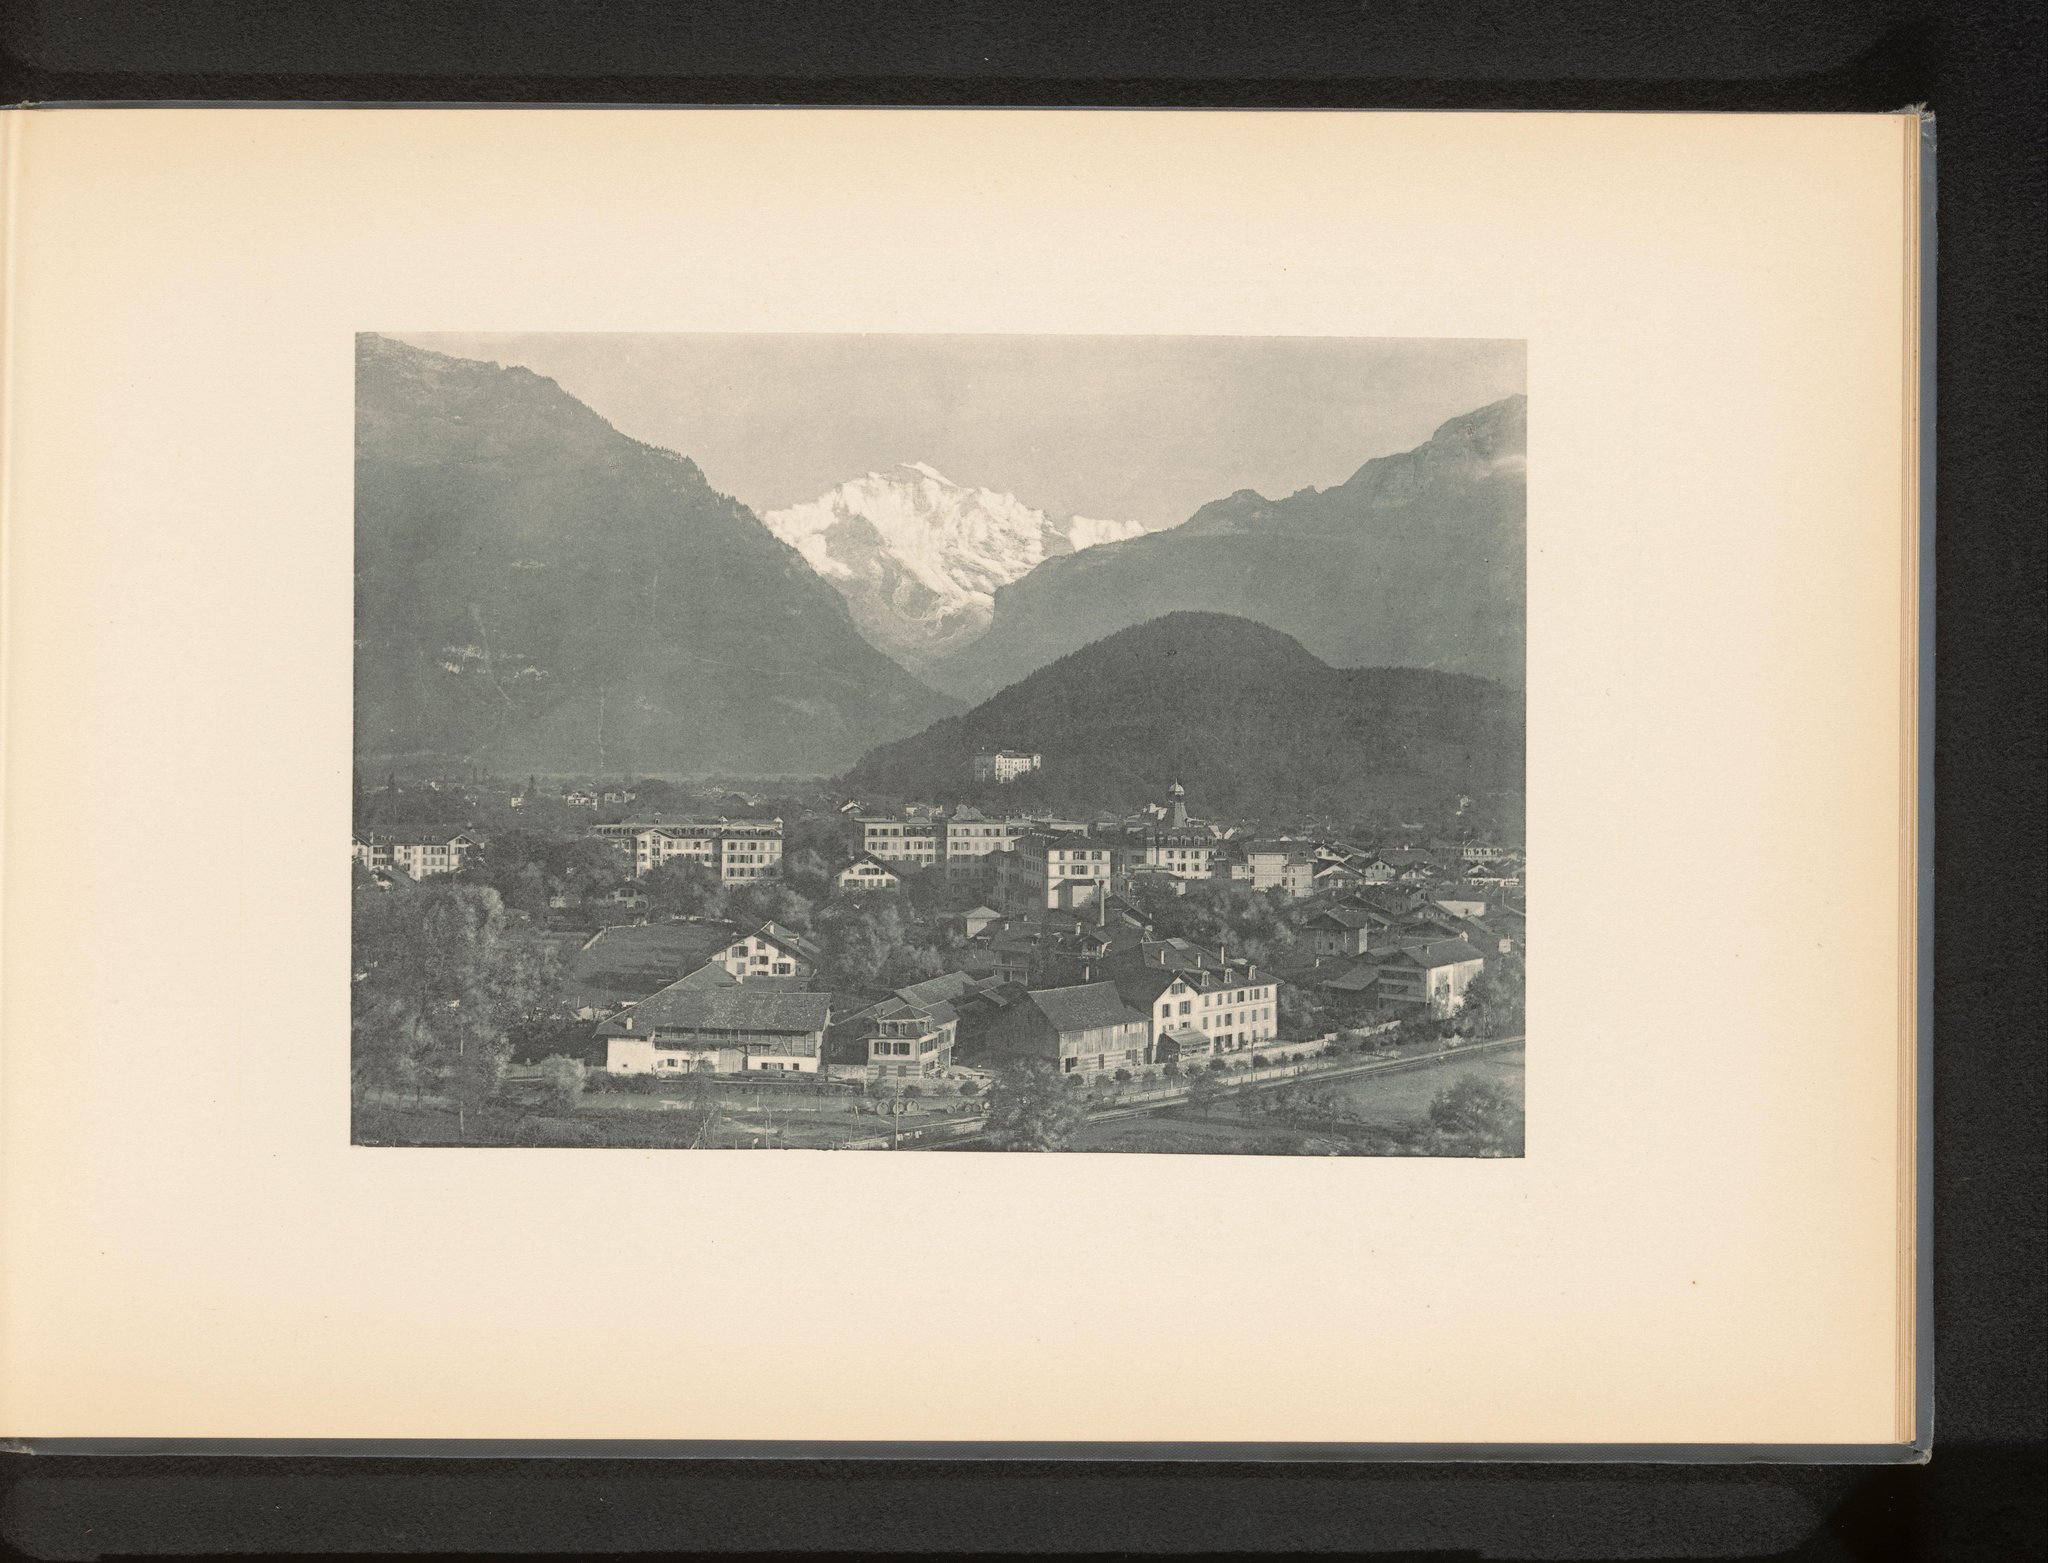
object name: page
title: Gezicht op Interlaken en de berg Jungfrau, Zwitserland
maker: Anonymous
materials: paper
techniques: photograph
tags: prospect of city, town panorama, silhouette of city, mountains